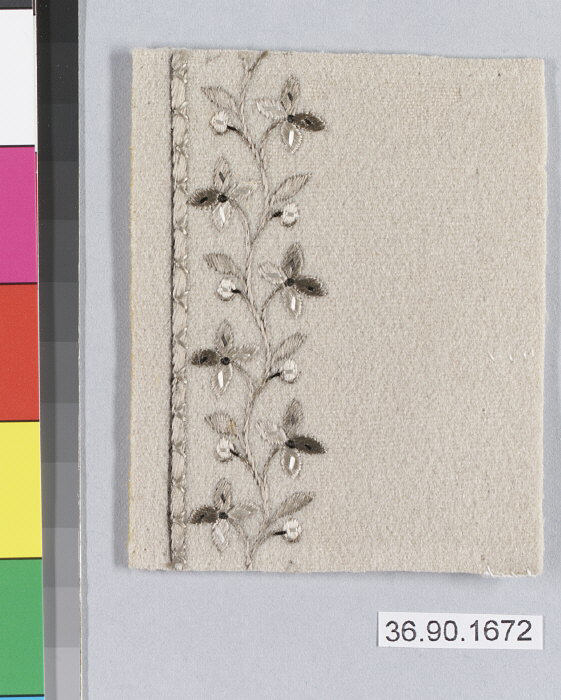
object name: sample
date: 1801-1833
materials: felt, silk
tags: flowers